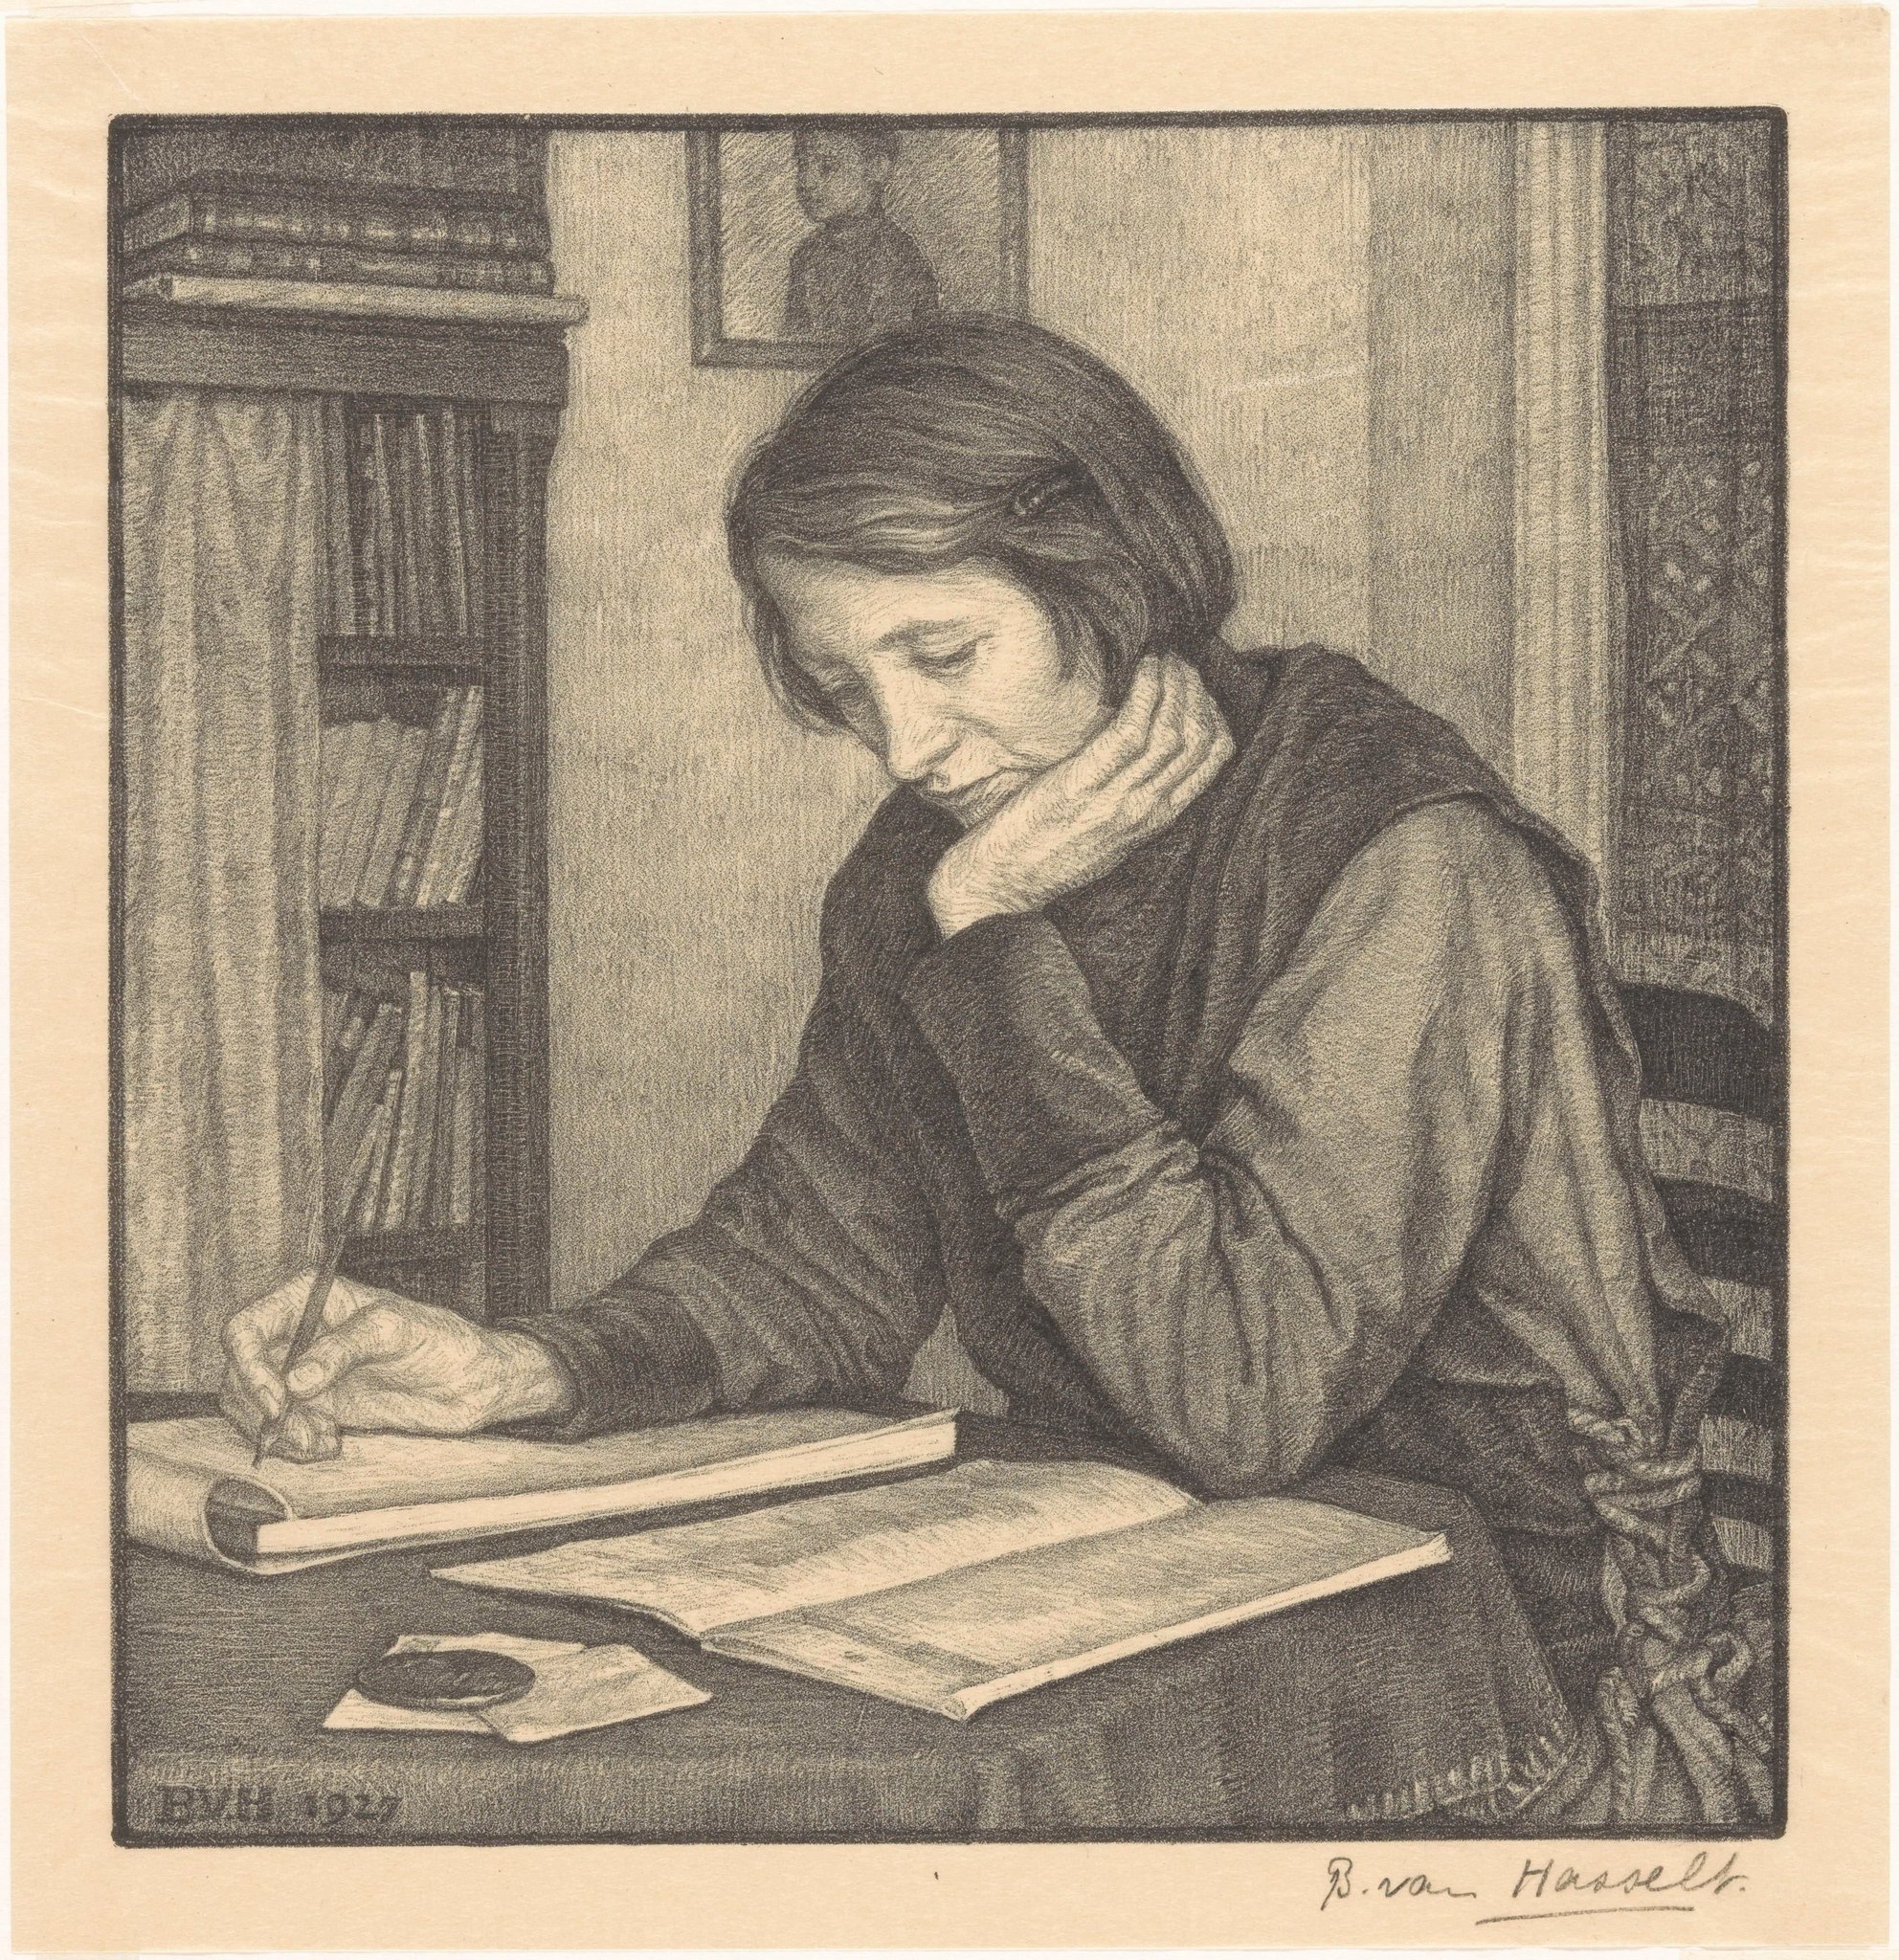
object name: print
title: Portret van Sanne Bruinier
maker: bertha van hasselt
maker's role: print maker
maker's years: 1878-1932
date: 1927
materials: paper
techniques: lithograph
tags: painter, draughtsman, book, portrait, self-portrait of artist, writing and letters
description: Kunstenares Sanne Bruinier, schrijvend aan een tafel. Links op de achtergrond een boekenkast en een portret van een kind.